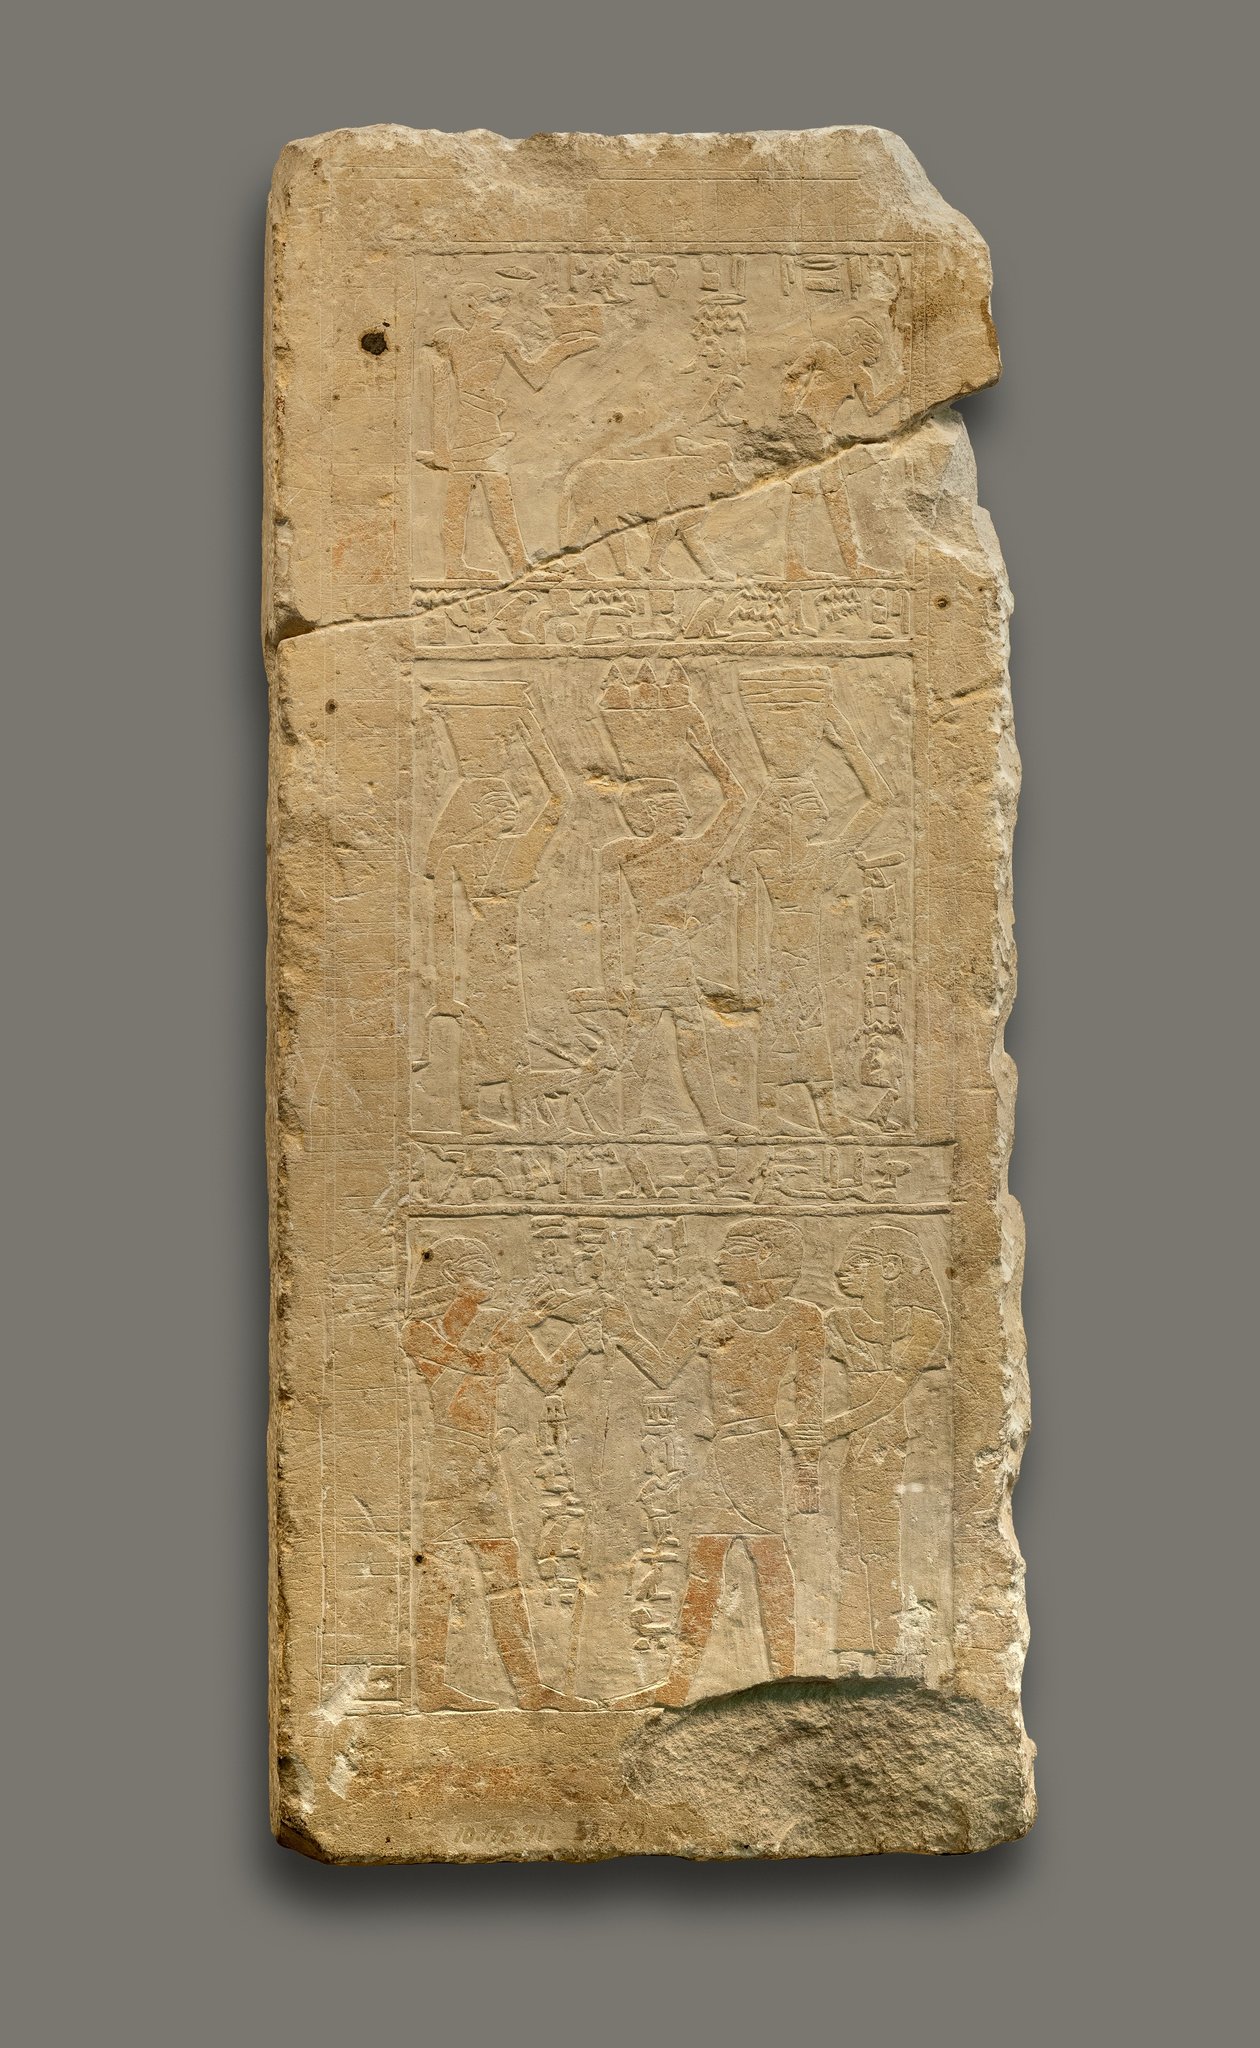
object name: false door, niche of inpuemhat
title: Relief from the Offering Niche of Inpuemhat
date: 2100-2010 BCE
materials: limestone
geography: egypt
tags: hieroglyphs